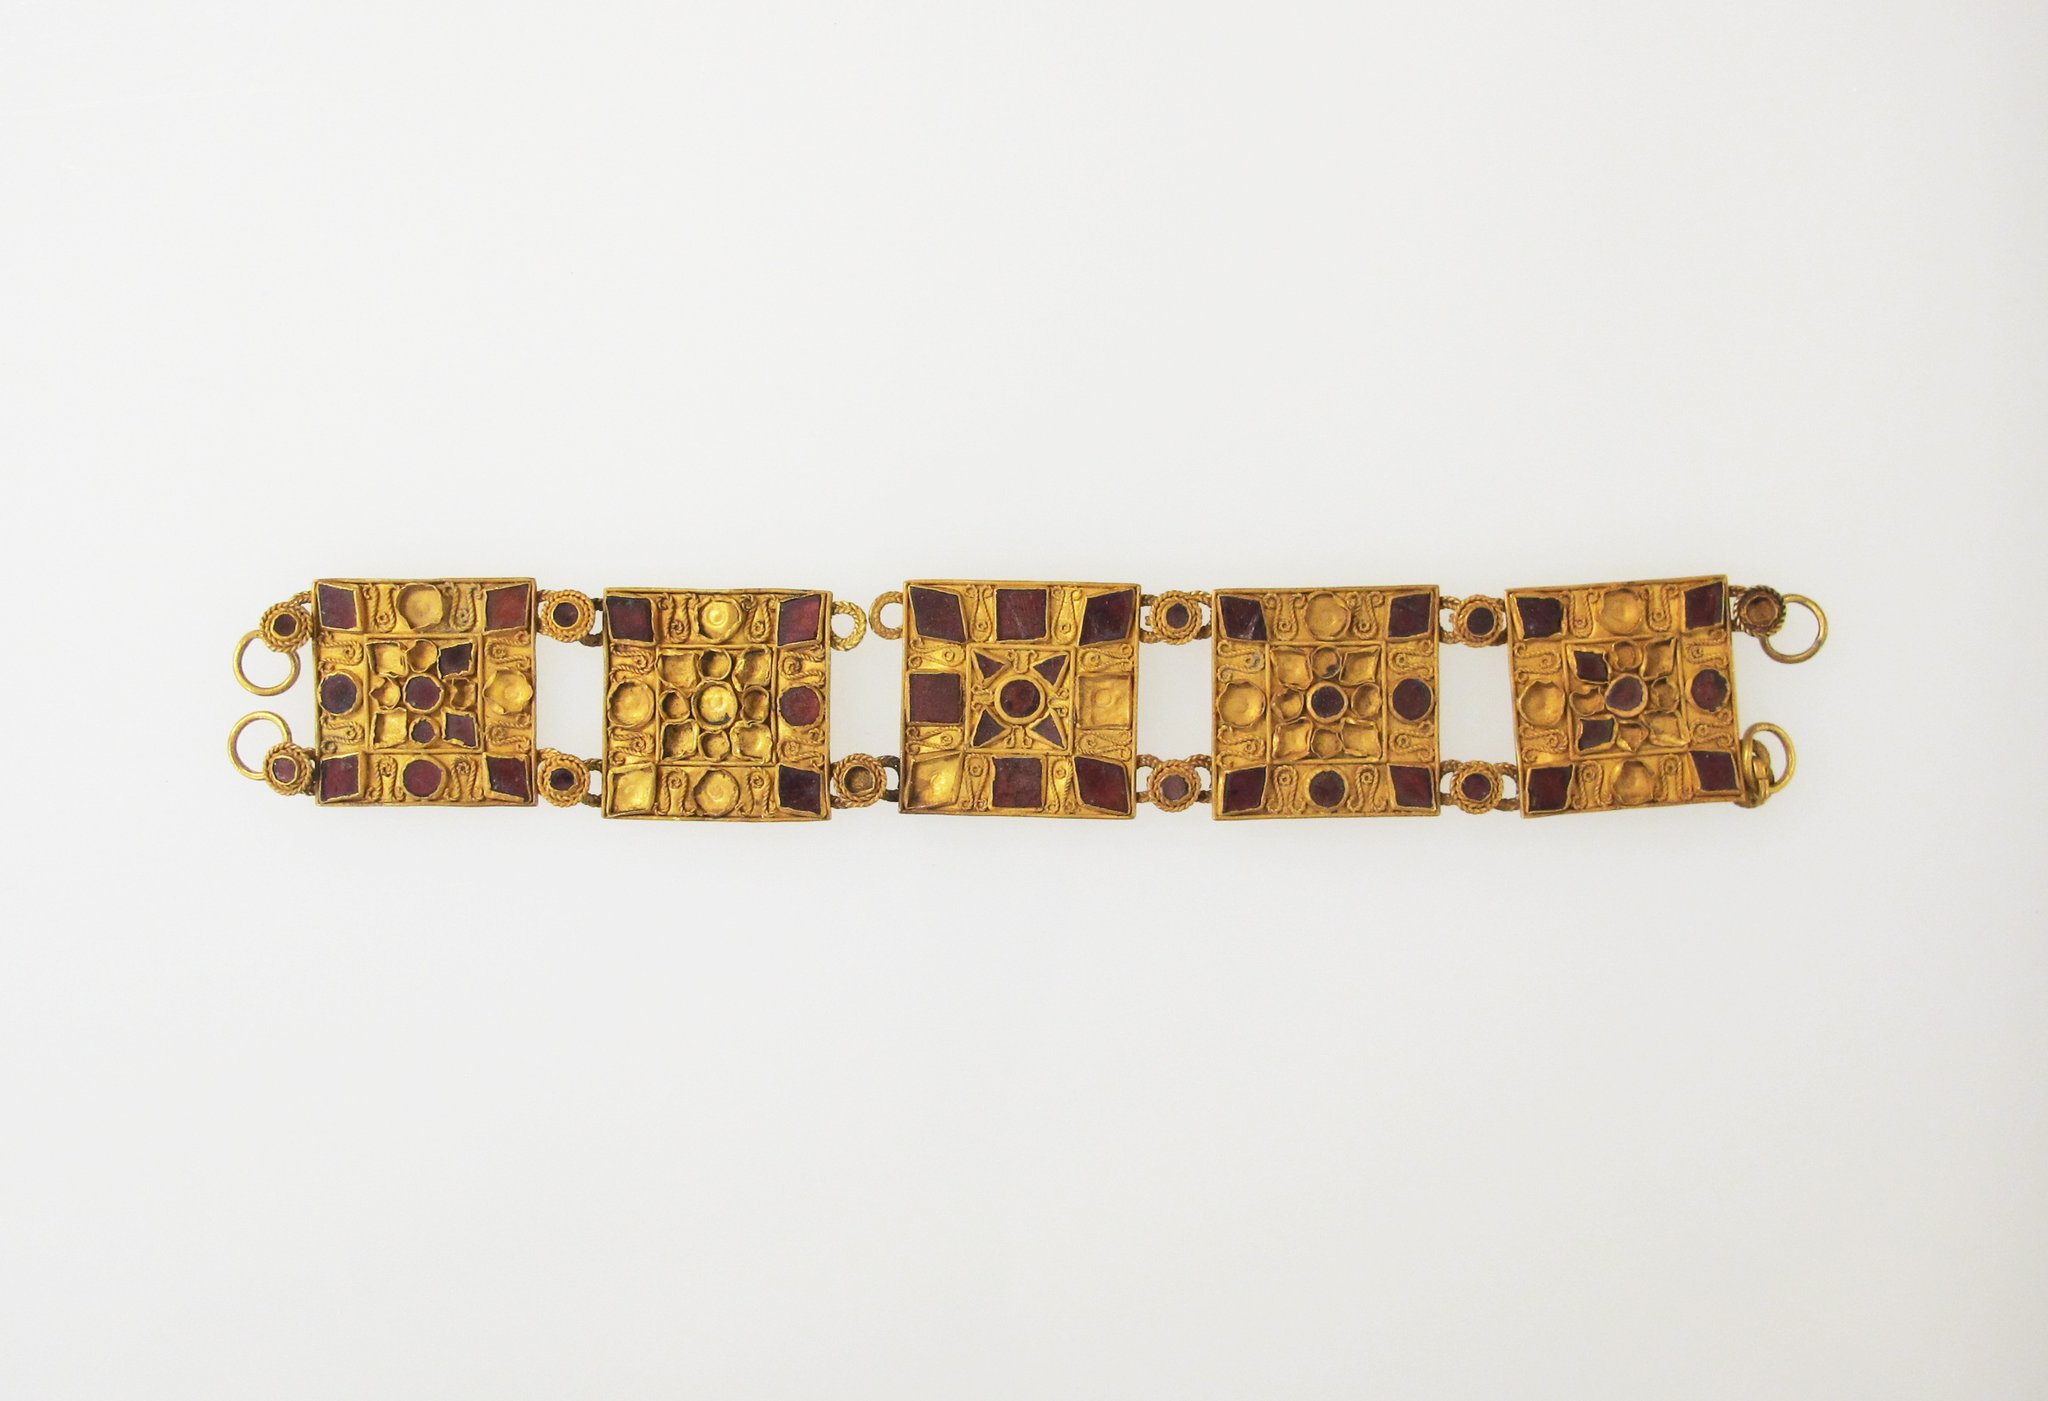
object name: bracelet with glass inlay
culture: roman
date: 201-400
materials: glass, gold